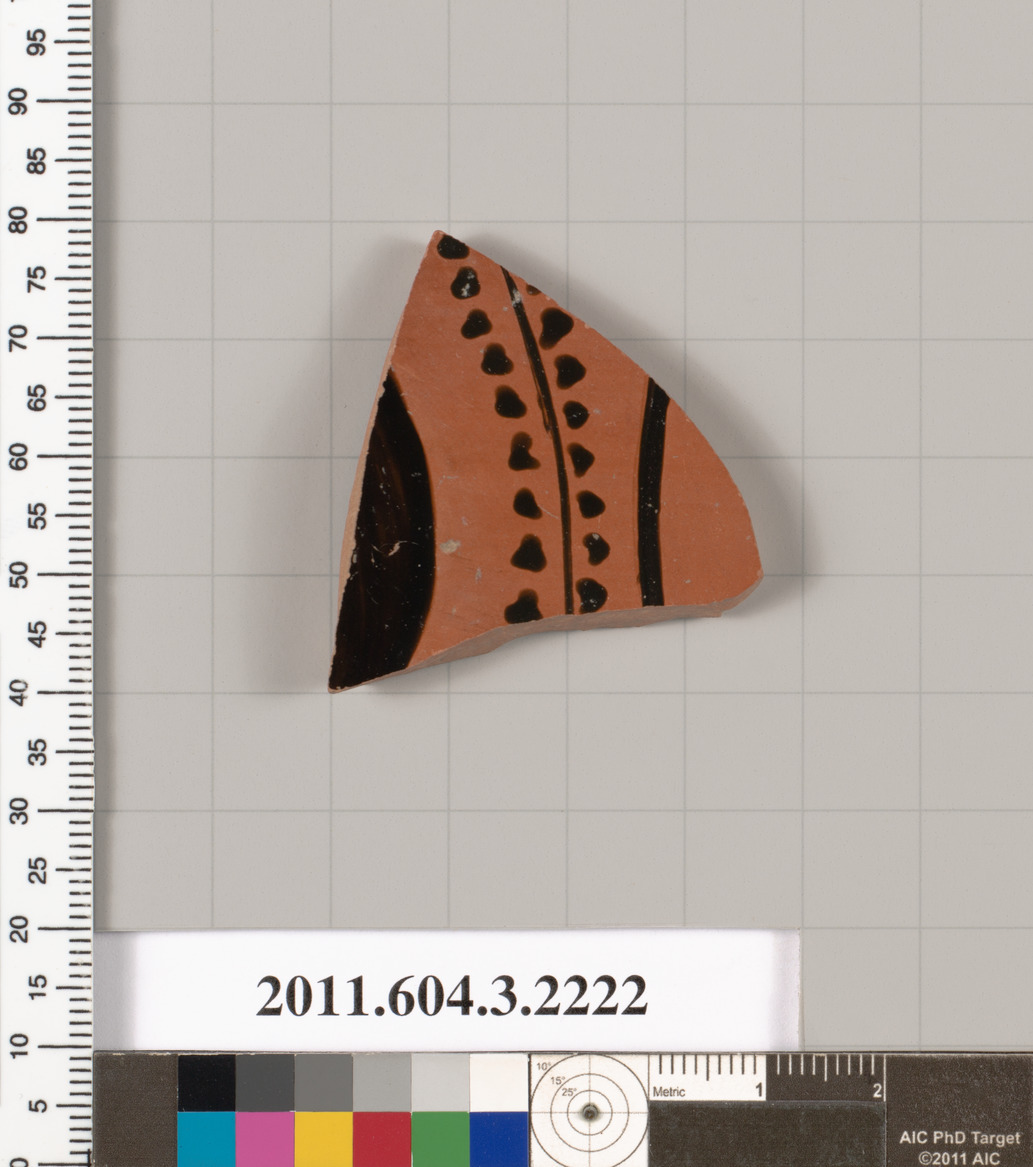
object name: kylix fragment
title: Terracotta fragment of a kylix (drinking cup)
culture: greek, attic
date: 525-501 BCE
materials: terracotta